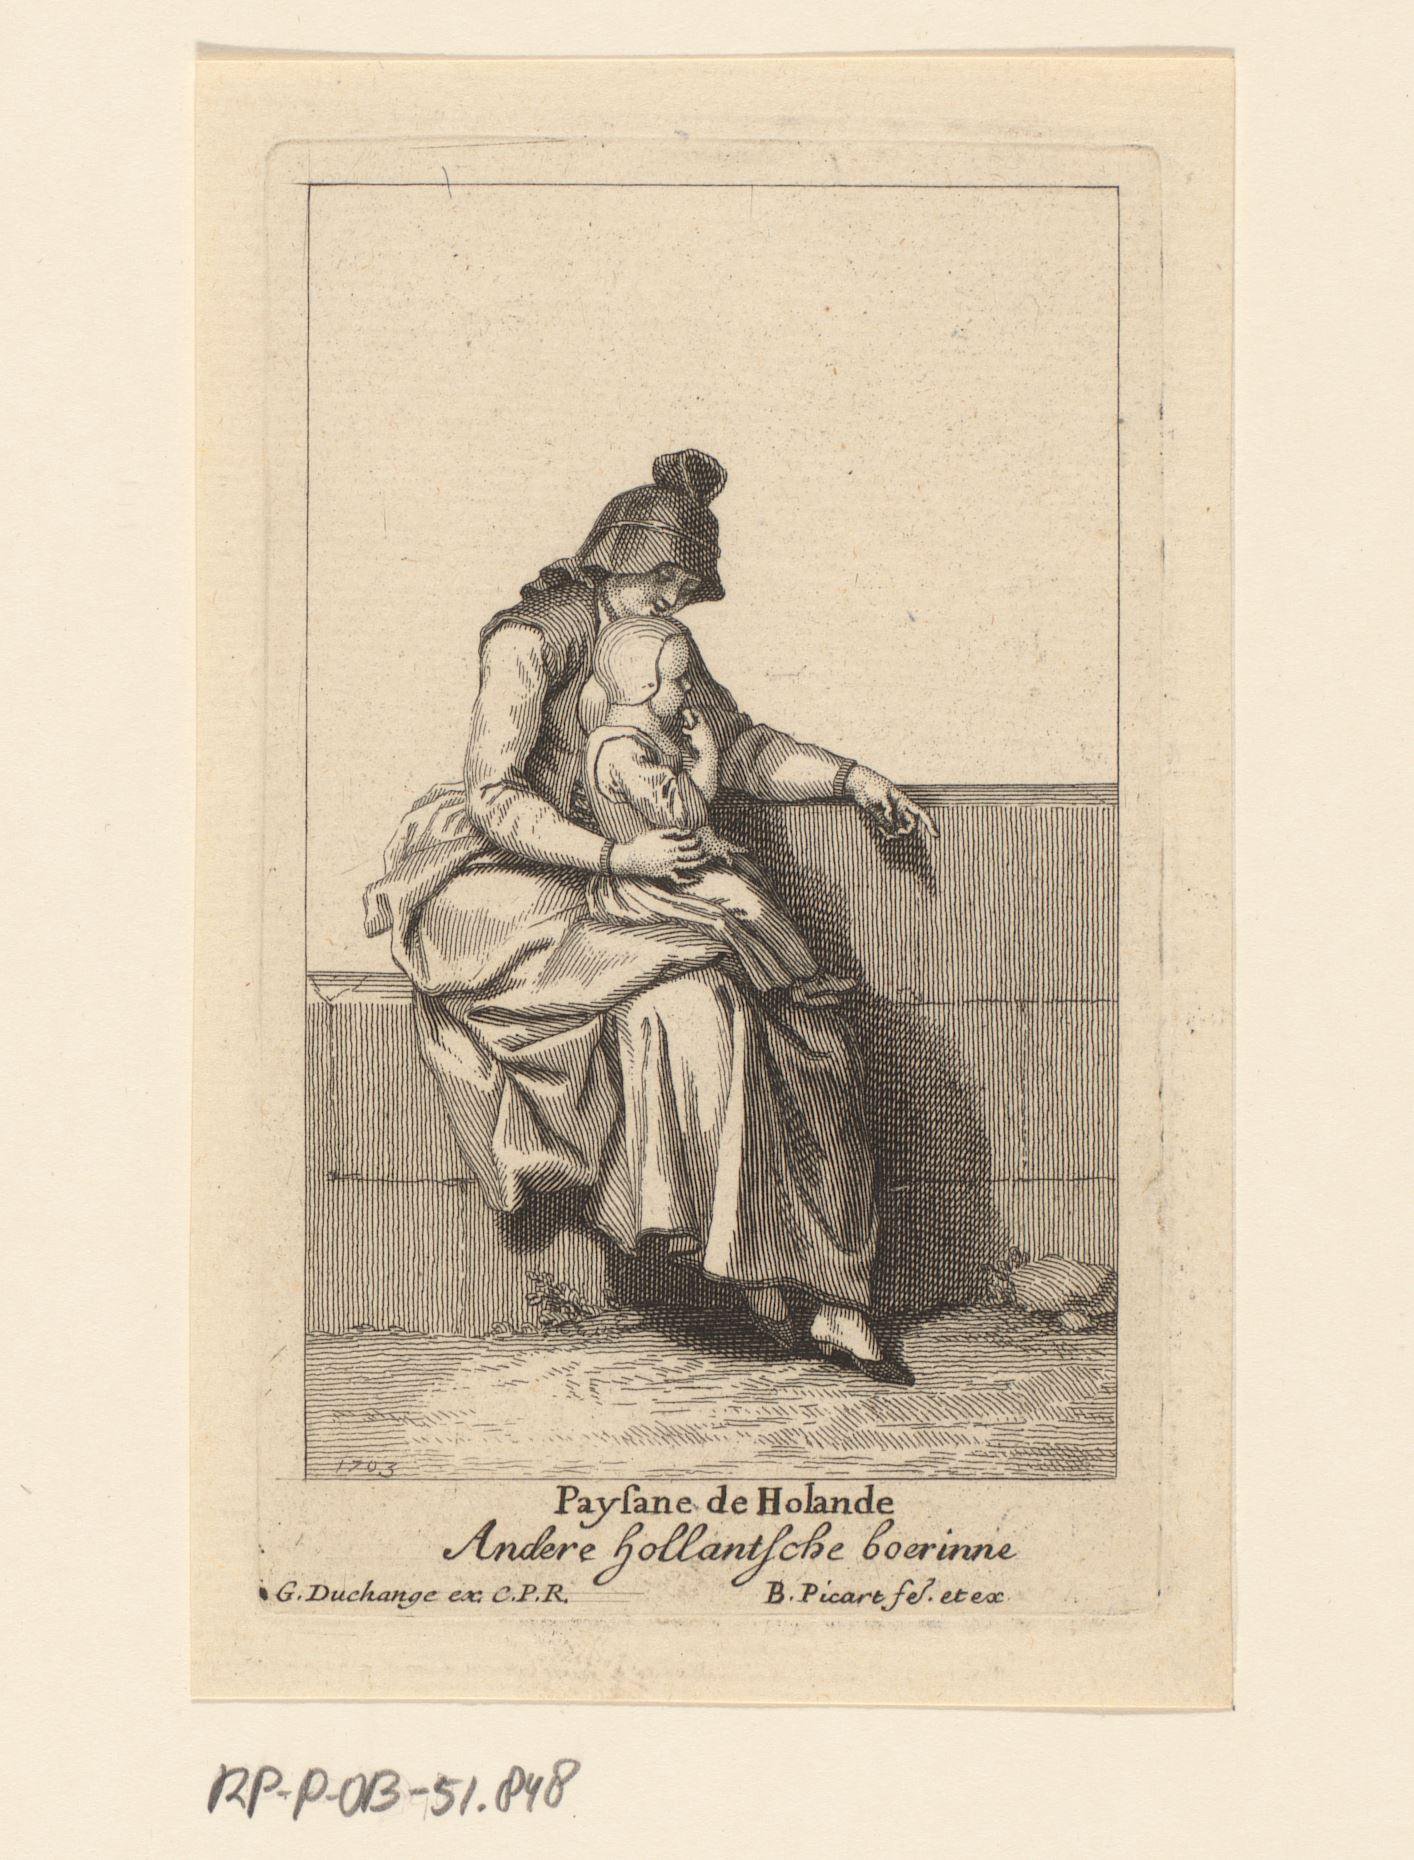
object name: costume print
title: Diverses modes Dessinées d'apres Nature (...)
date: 1703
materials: paper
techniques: engraving, etching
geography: amsterdam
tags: folk costume, regional costume, holland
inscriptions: date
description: Prent waarschijnlijk ook opgenomen in: Diverses modes dessinées d'après Nature. Amsterdam: Bernard Picart, 1728.